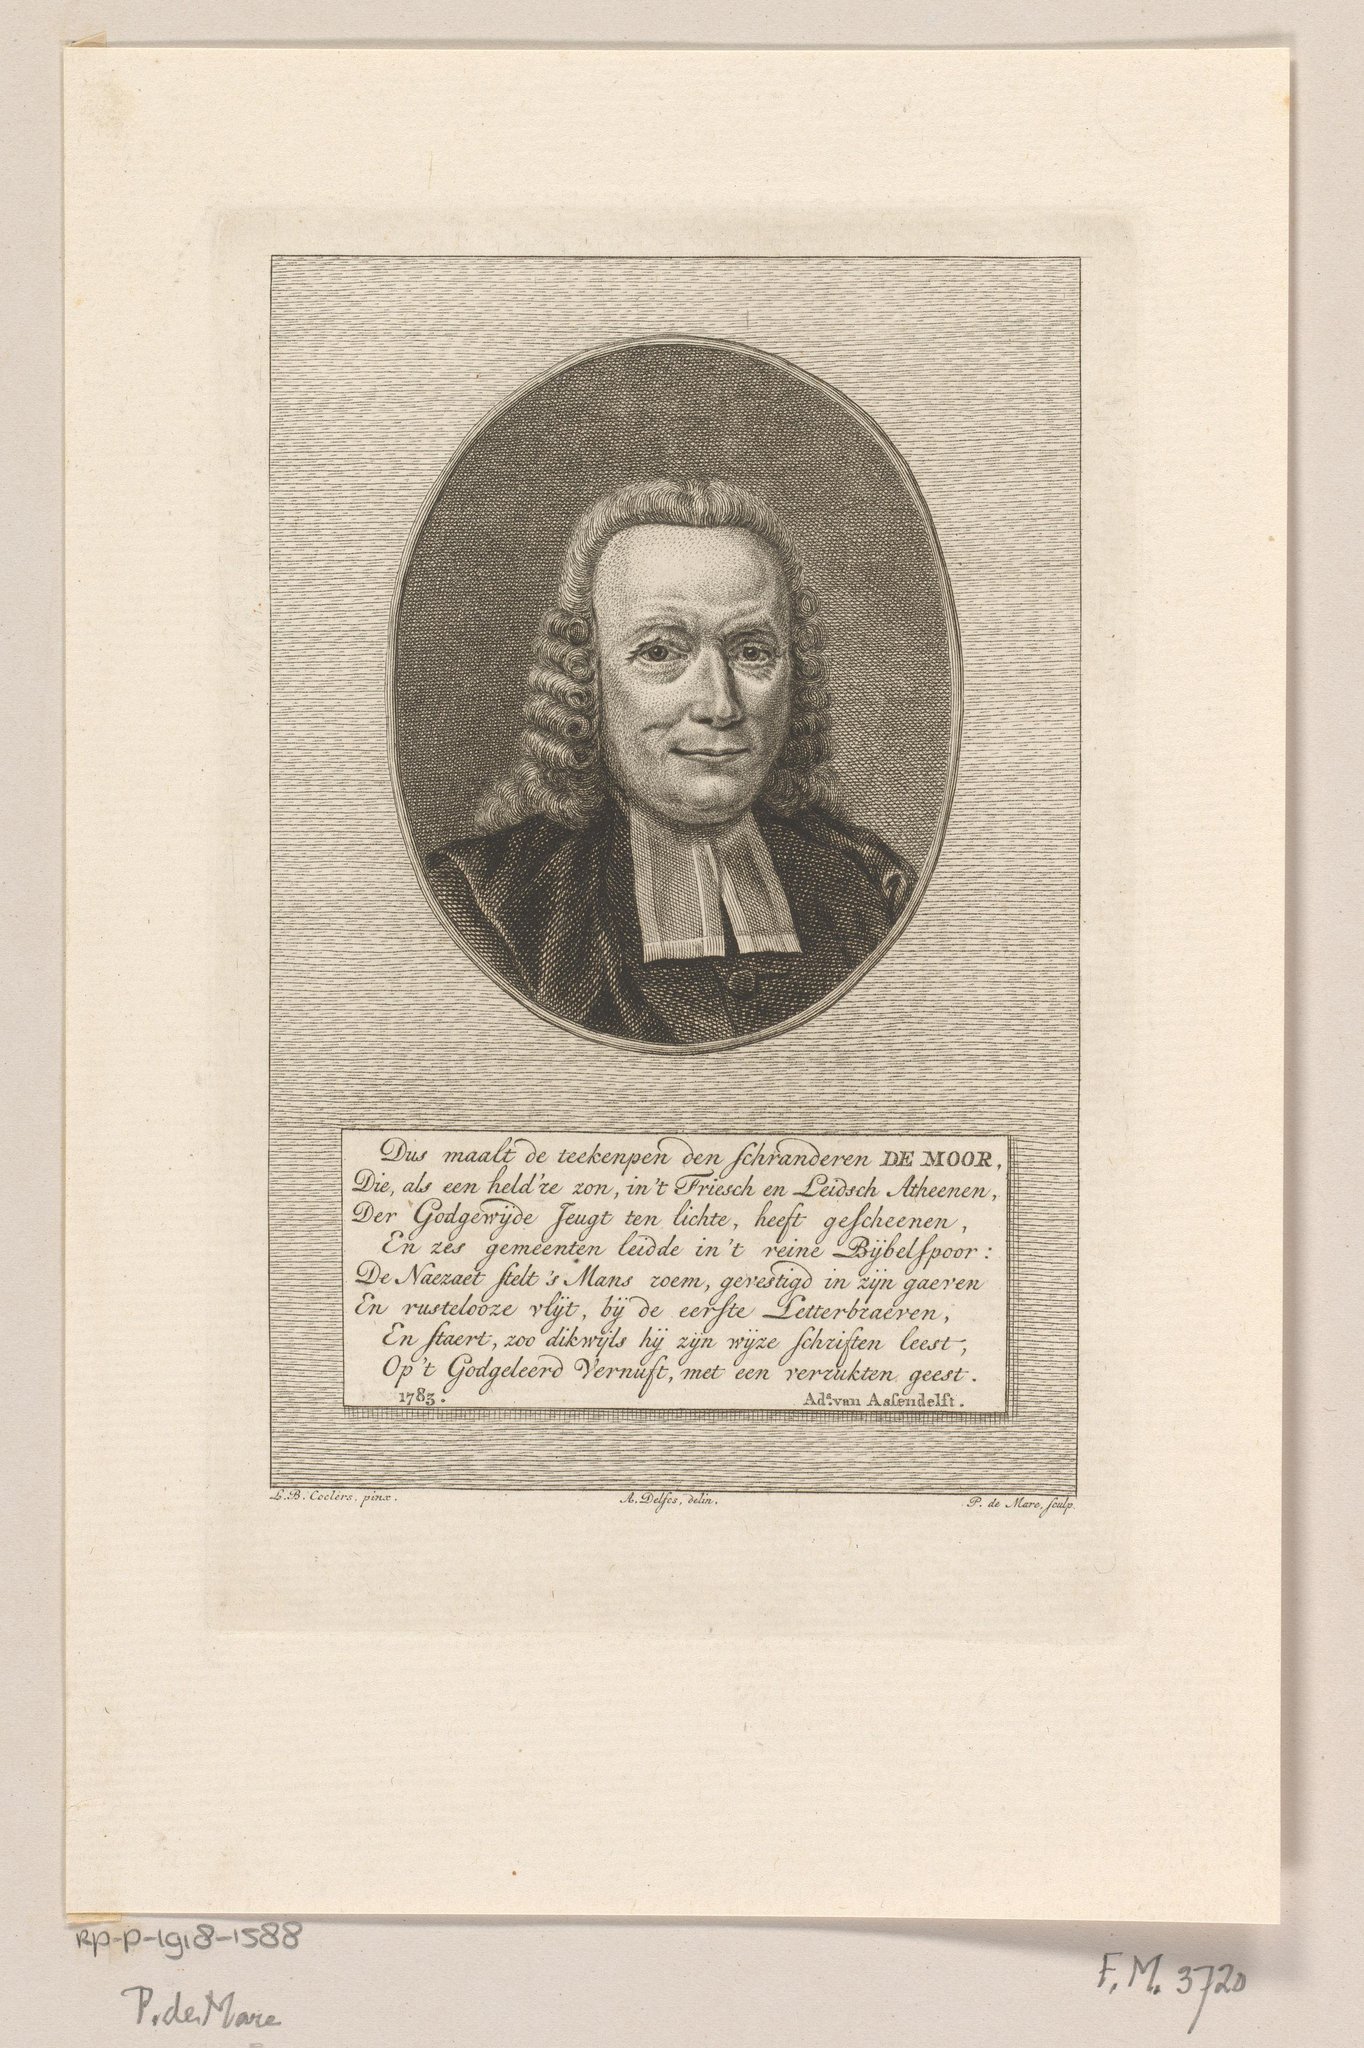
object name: print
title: Portret van Bernhardinus de Moor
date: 1783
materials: paper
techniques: engraving, etching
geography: leiden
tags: gouda, historical persons, functionaries and dignitaries ~ protestant churches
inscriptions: collector's mark: Lugt 2233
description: Met achtregelig onderschrift in het Nederlands.